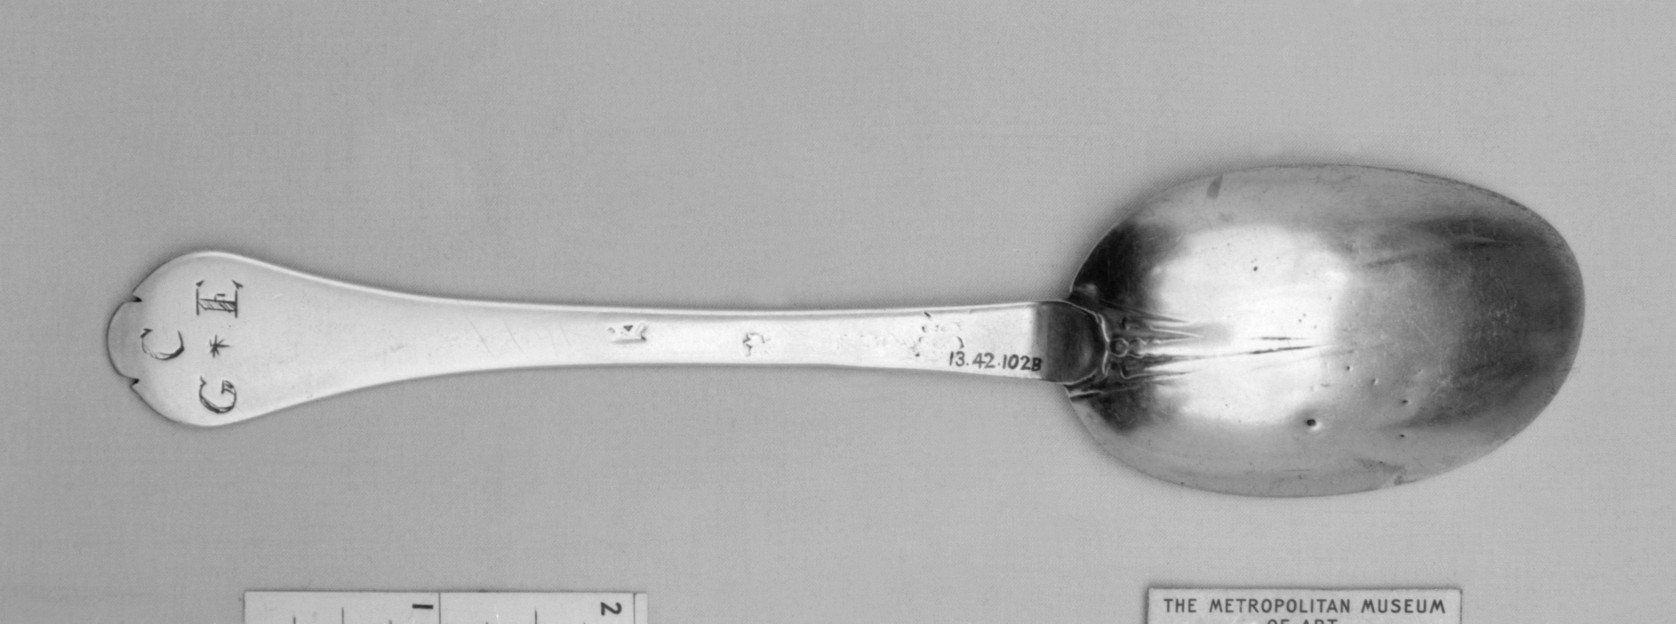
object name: spoon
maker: william scarlett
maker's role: maker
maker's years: 1689-1697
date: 1697-1698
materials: silver